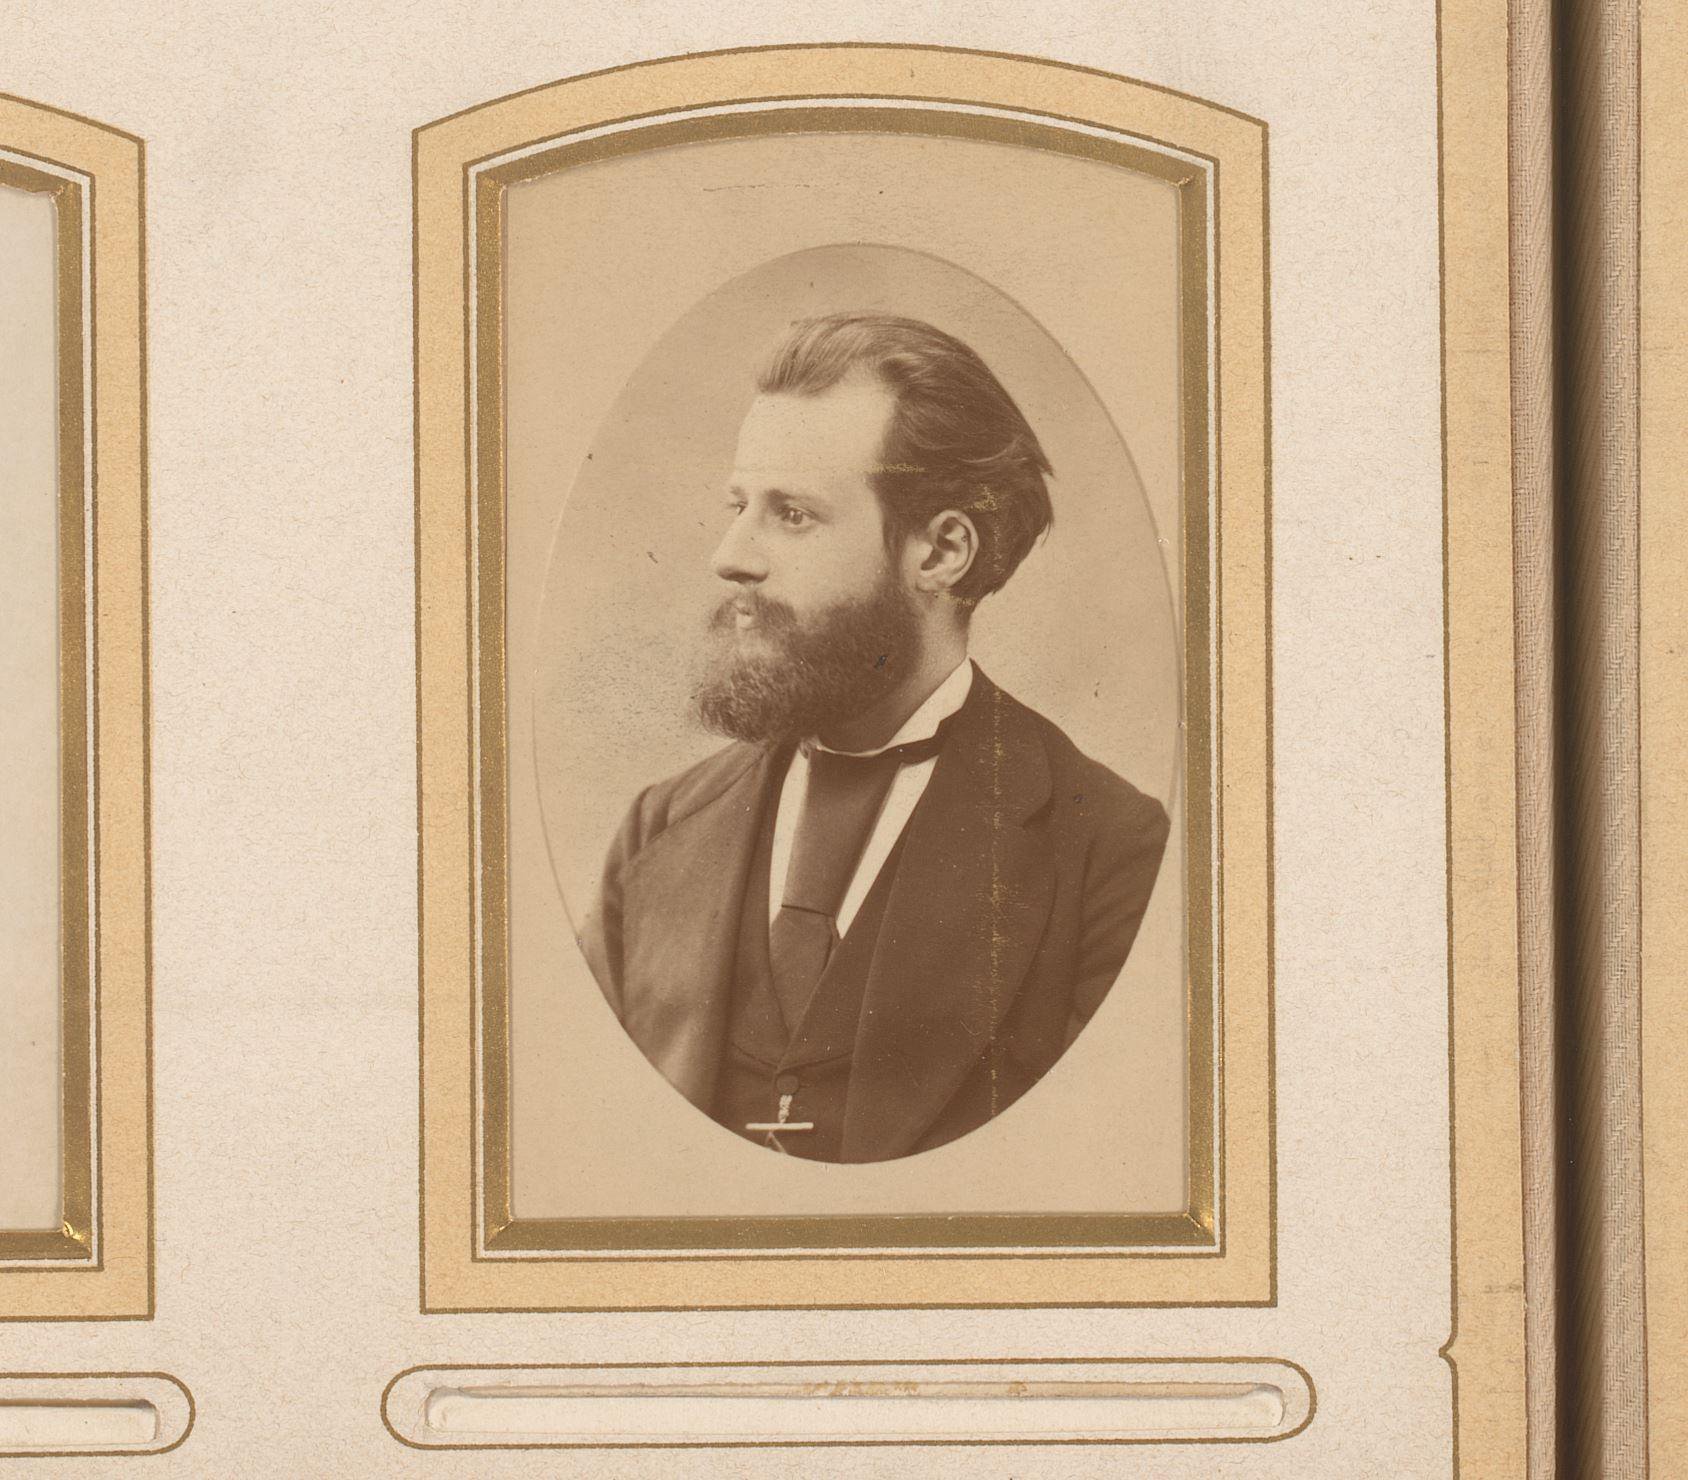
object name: photograph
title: Portret van een man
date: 1860-1880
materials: cardboard, photographic support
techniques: albumen print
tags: adult man, historical persons